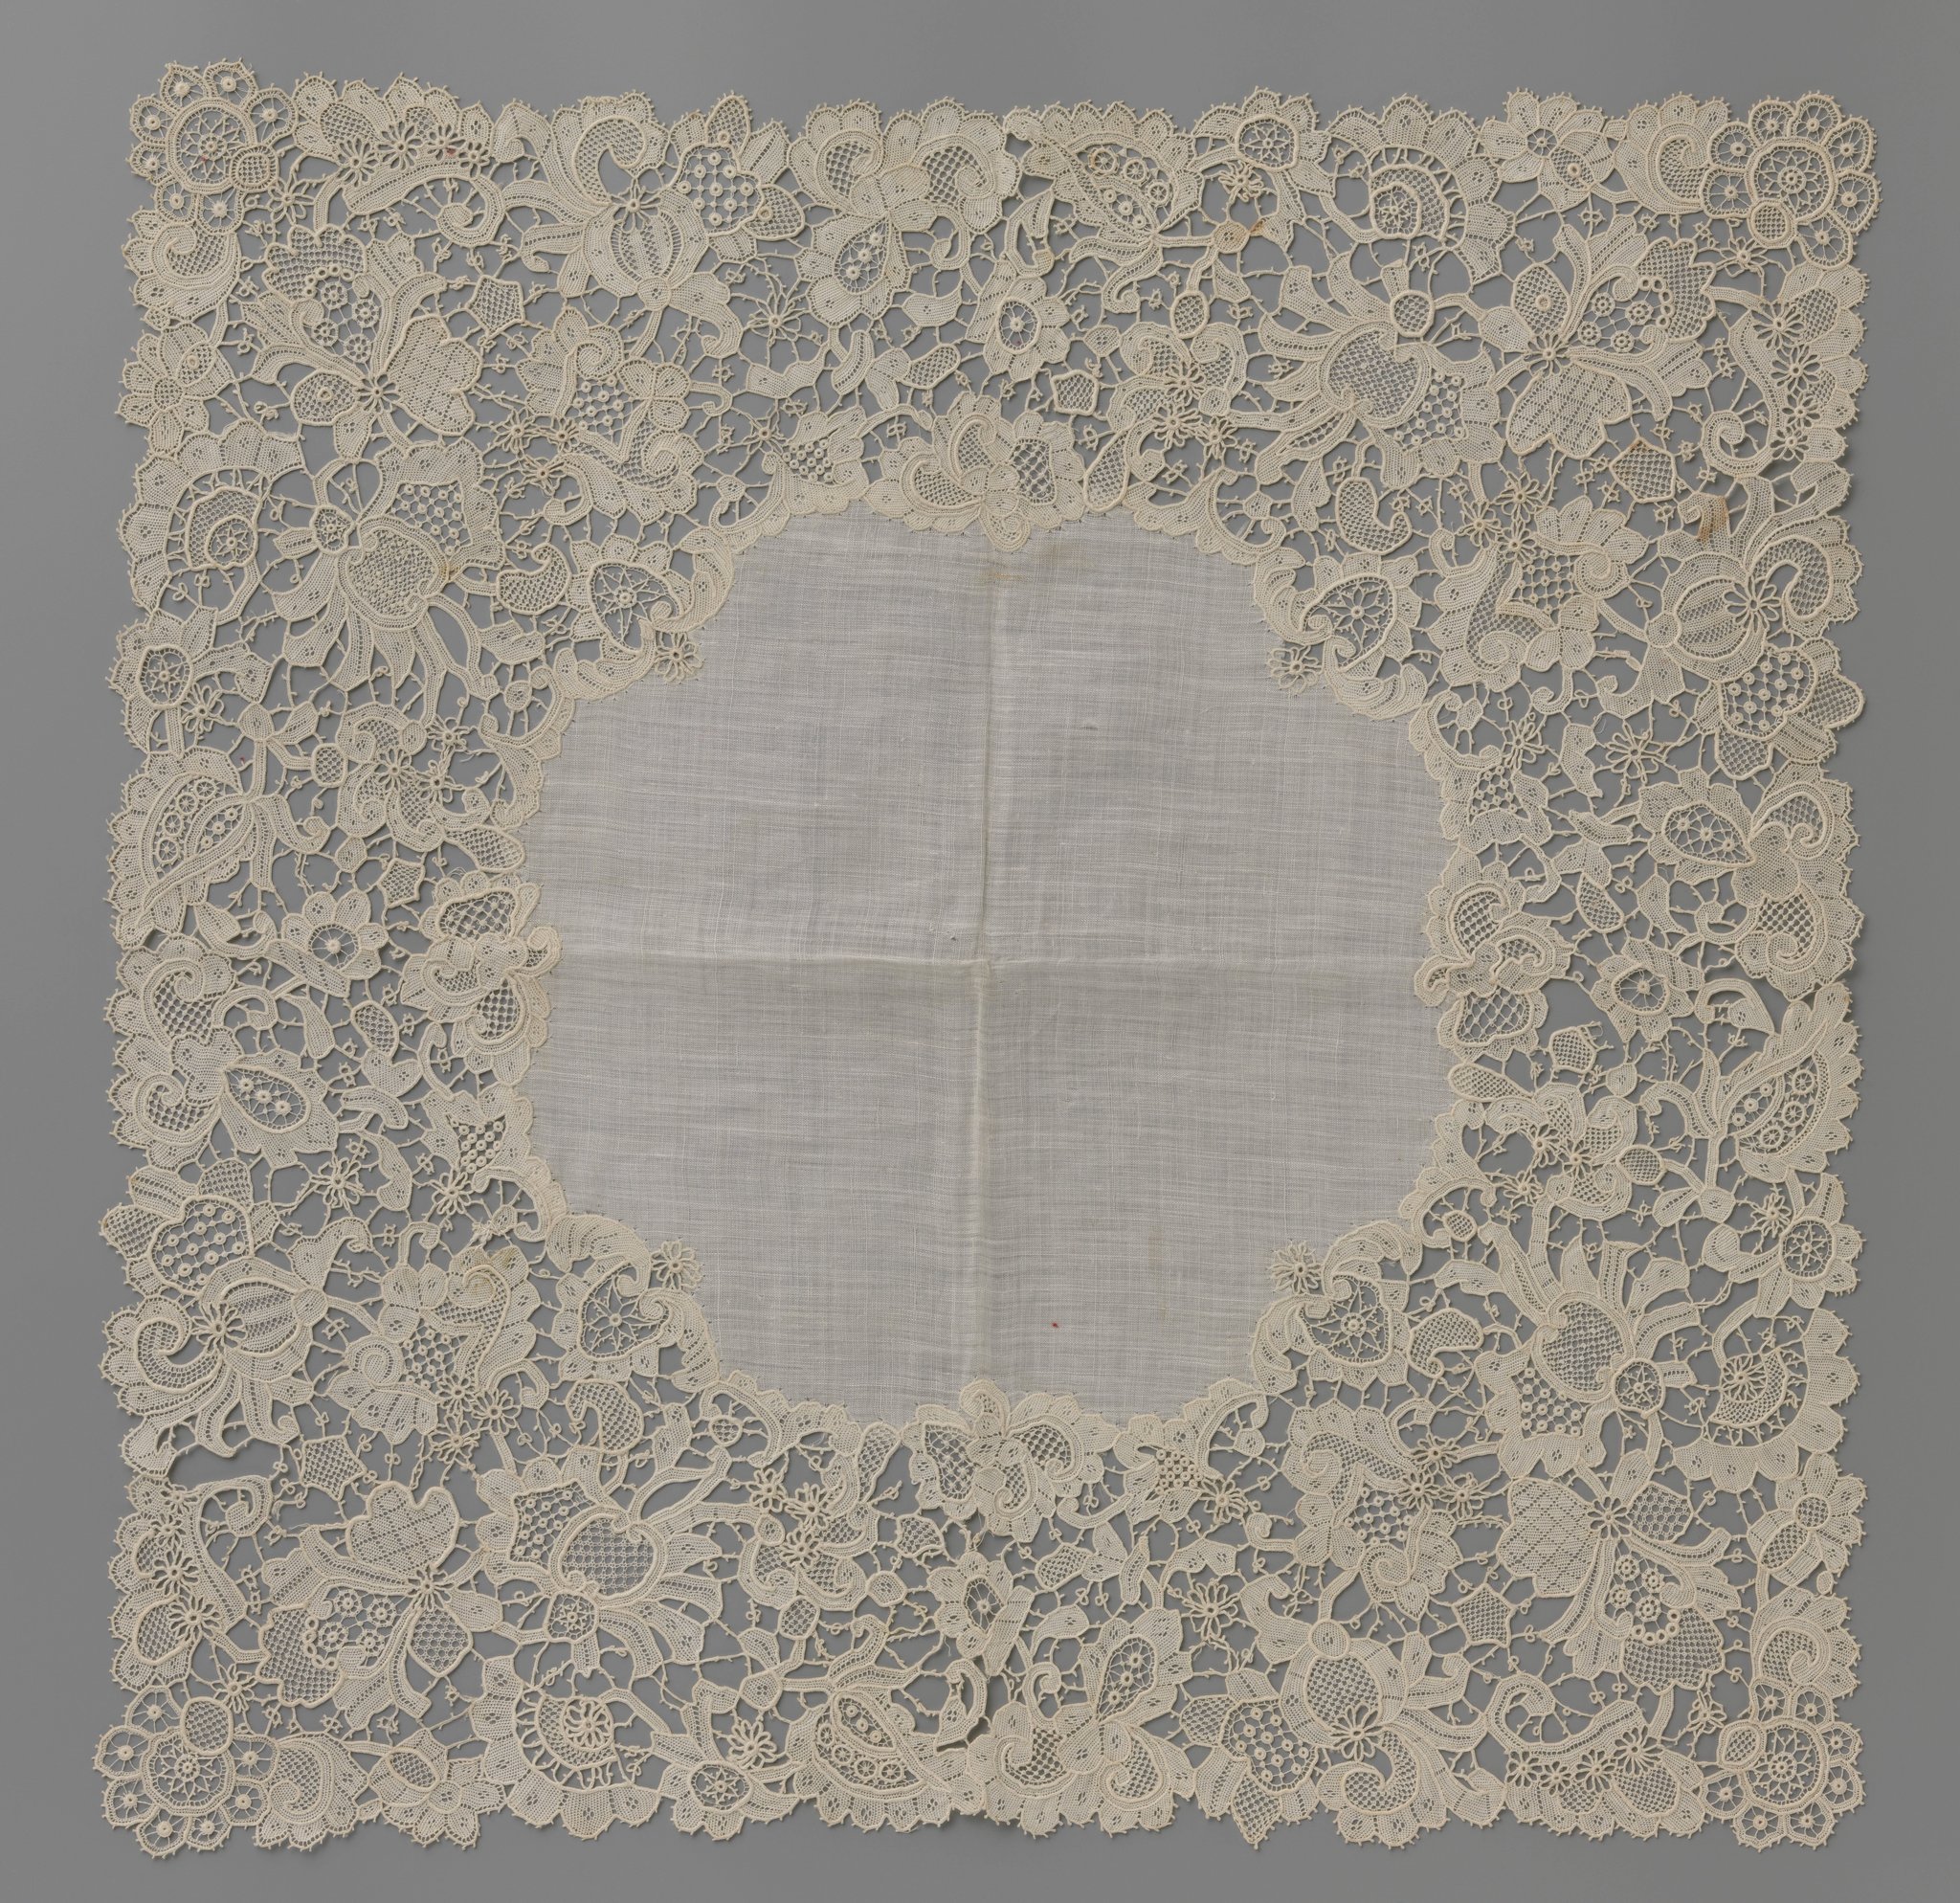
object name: handkerchief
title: Zakdoek van naaldkant met bloemen en een binnenstuk van batist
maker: Anonymous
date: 1870-1909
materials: linen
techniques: embroidery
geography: burano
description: Zakdoek van batist met een brede rand naturelkleurige naaldkant: Venetiaanse reliëfkant. Het binnenstuk van linnen batist is geschulpt en rozetvormig. Kant: op een spijlengrond staan ranken met veelsoortige bloemen, zoals waaiervormige palmetbloemen, paisley motieven, enzovoort, die asymmetrisch zijn gegroepeerd.